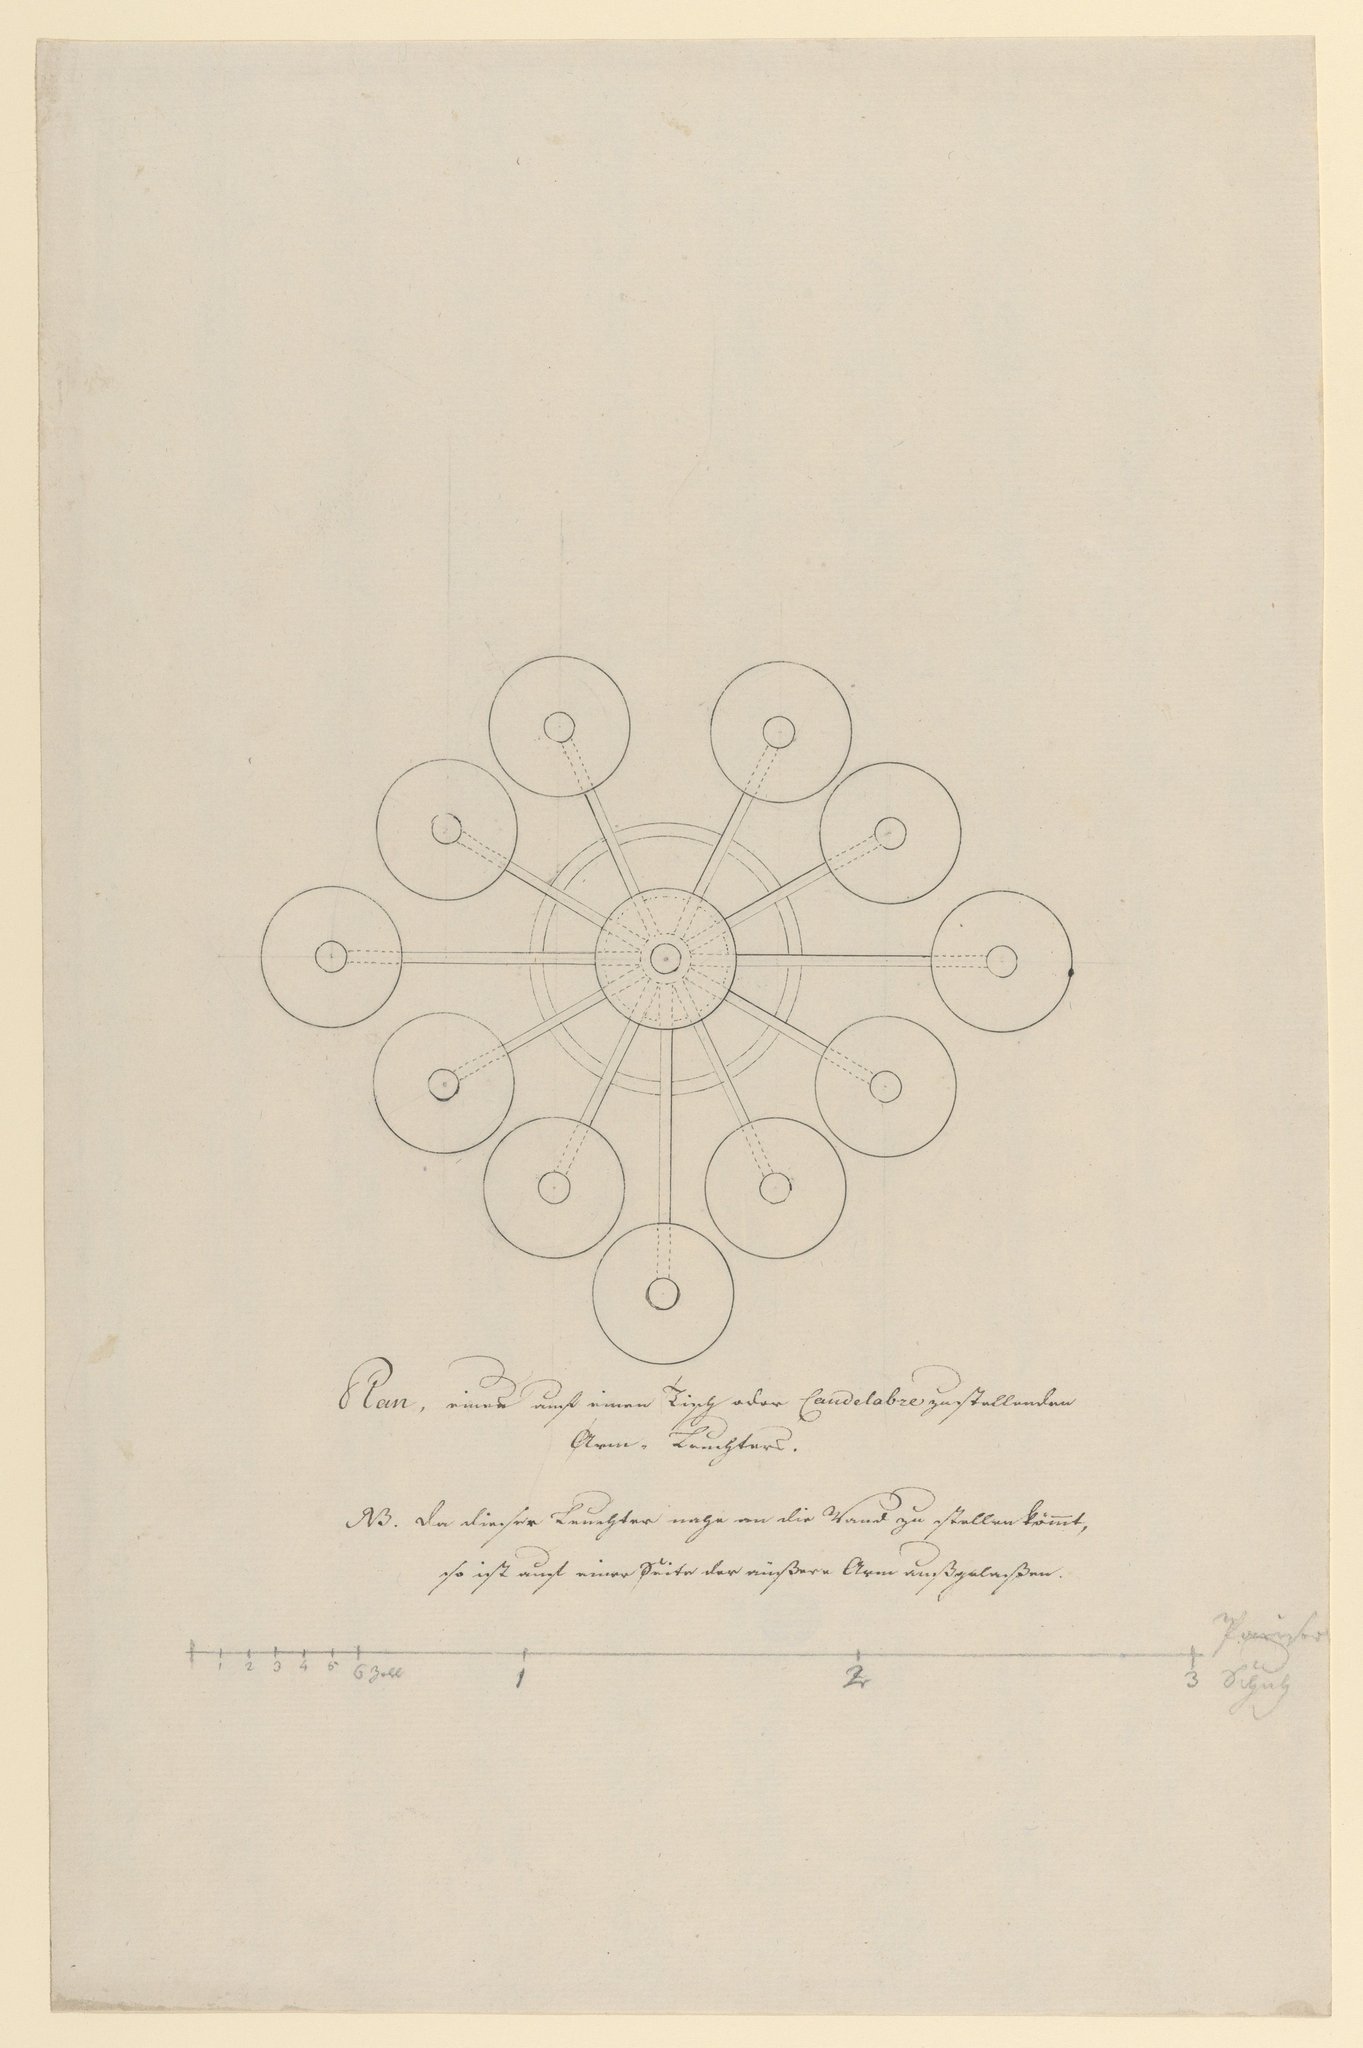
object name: drawing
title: Design for a Candelabra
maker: anonymous, french, 18th century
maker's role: artist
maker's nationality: french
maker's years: 1700-1800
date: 1770-1790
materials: graphite, ink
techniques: pen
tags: candelabra